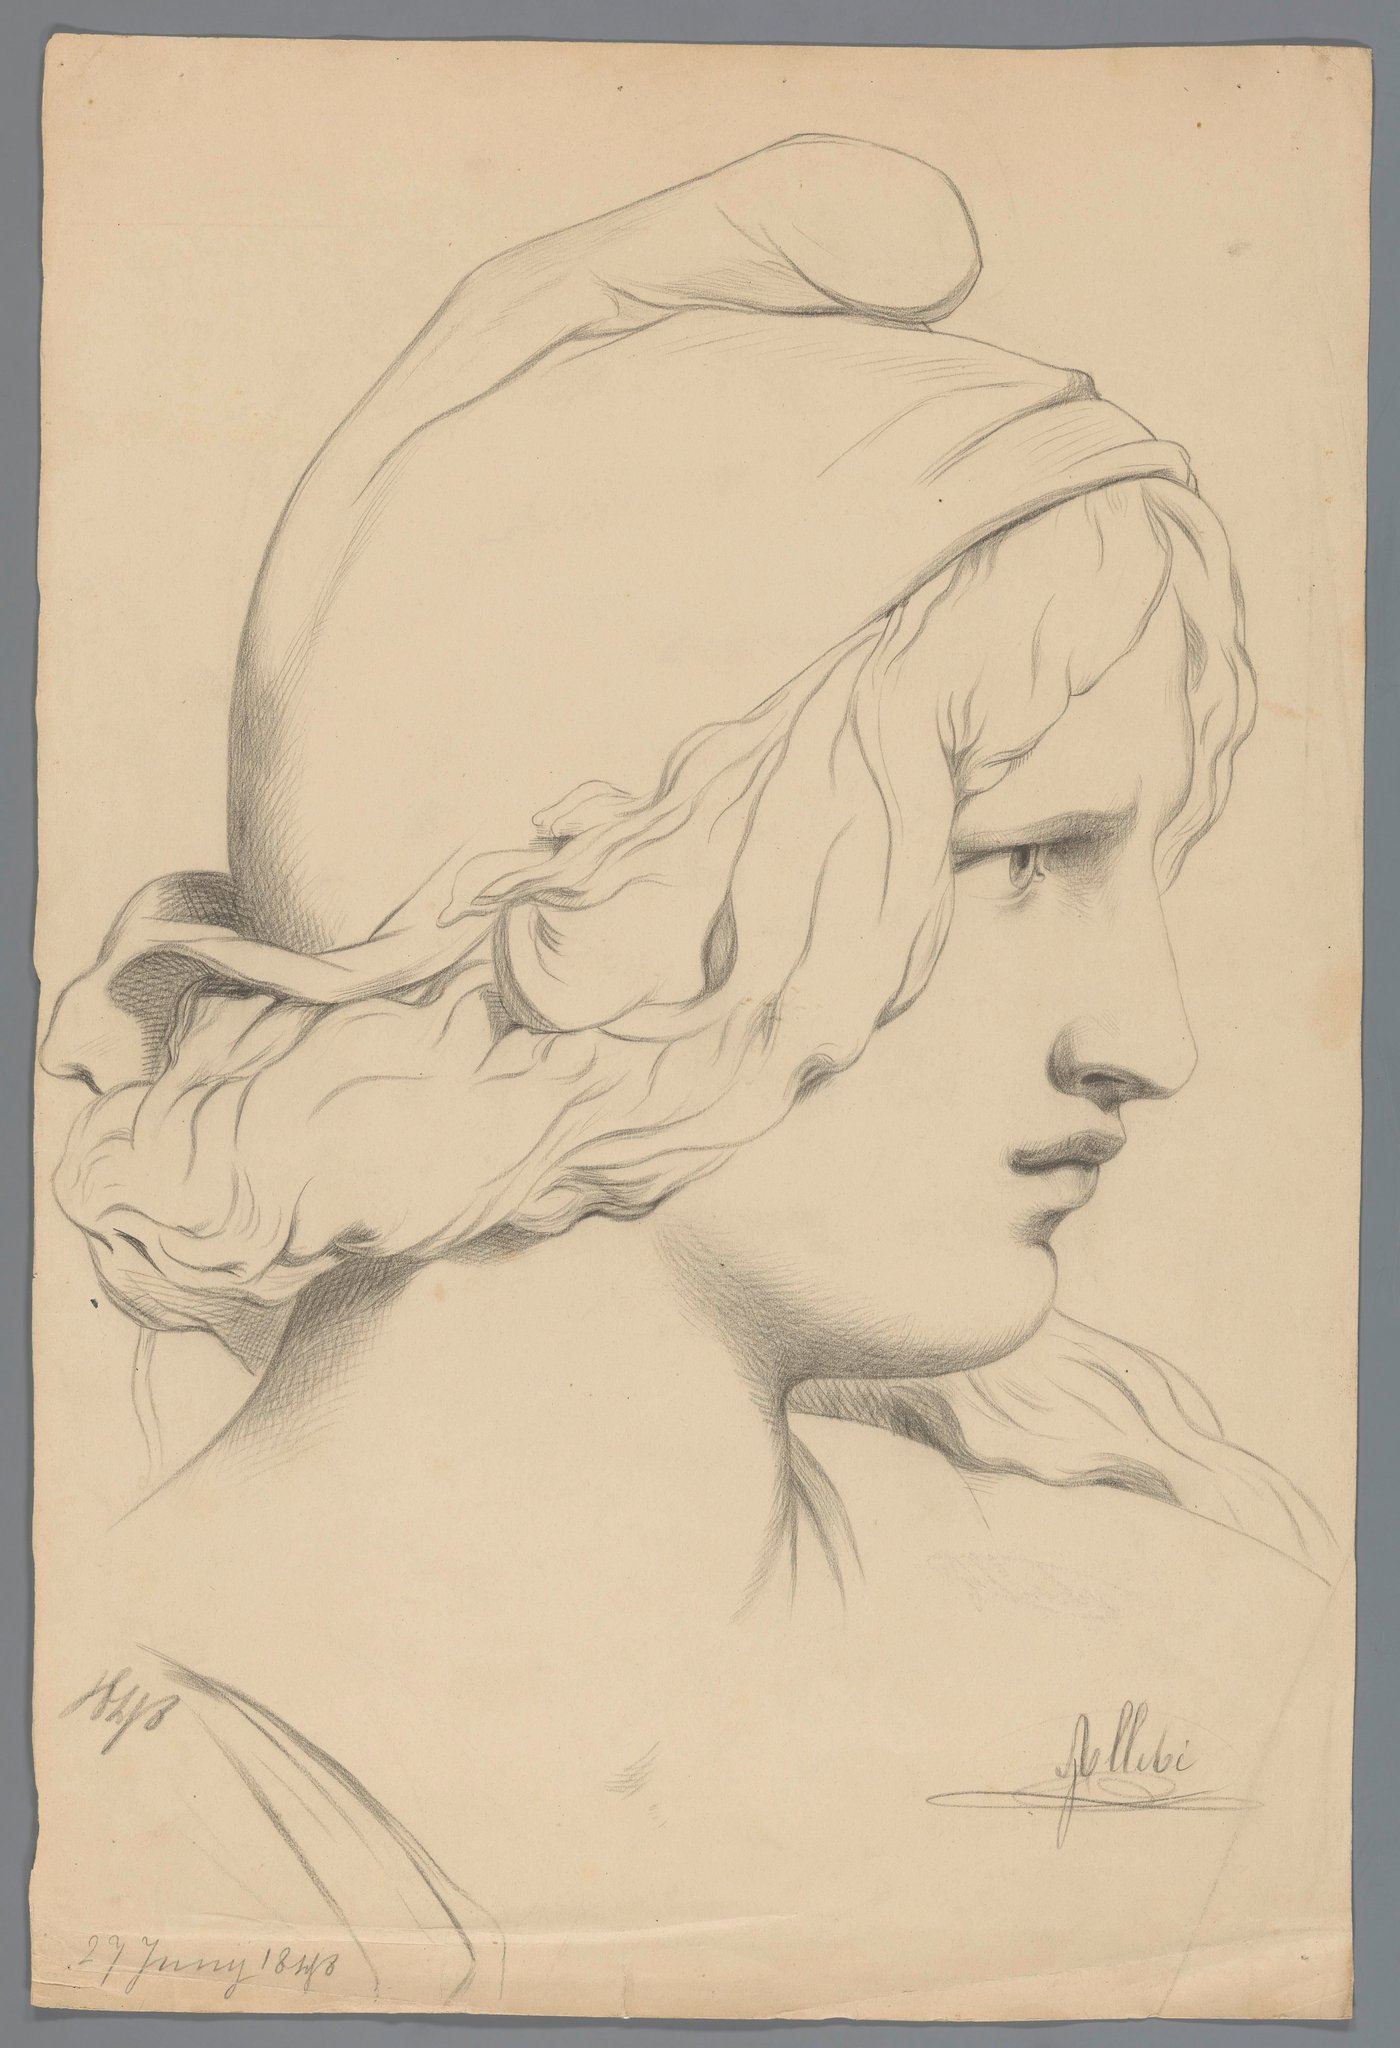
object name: drawing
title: Vrouwenkop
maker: august allebé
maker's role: draughtsman, print maker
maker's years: 1838-1927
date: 1848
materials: chalk, paper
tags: piece of sculpture, reproduction of a piece of sculpture, head (human) - aa - female human figure